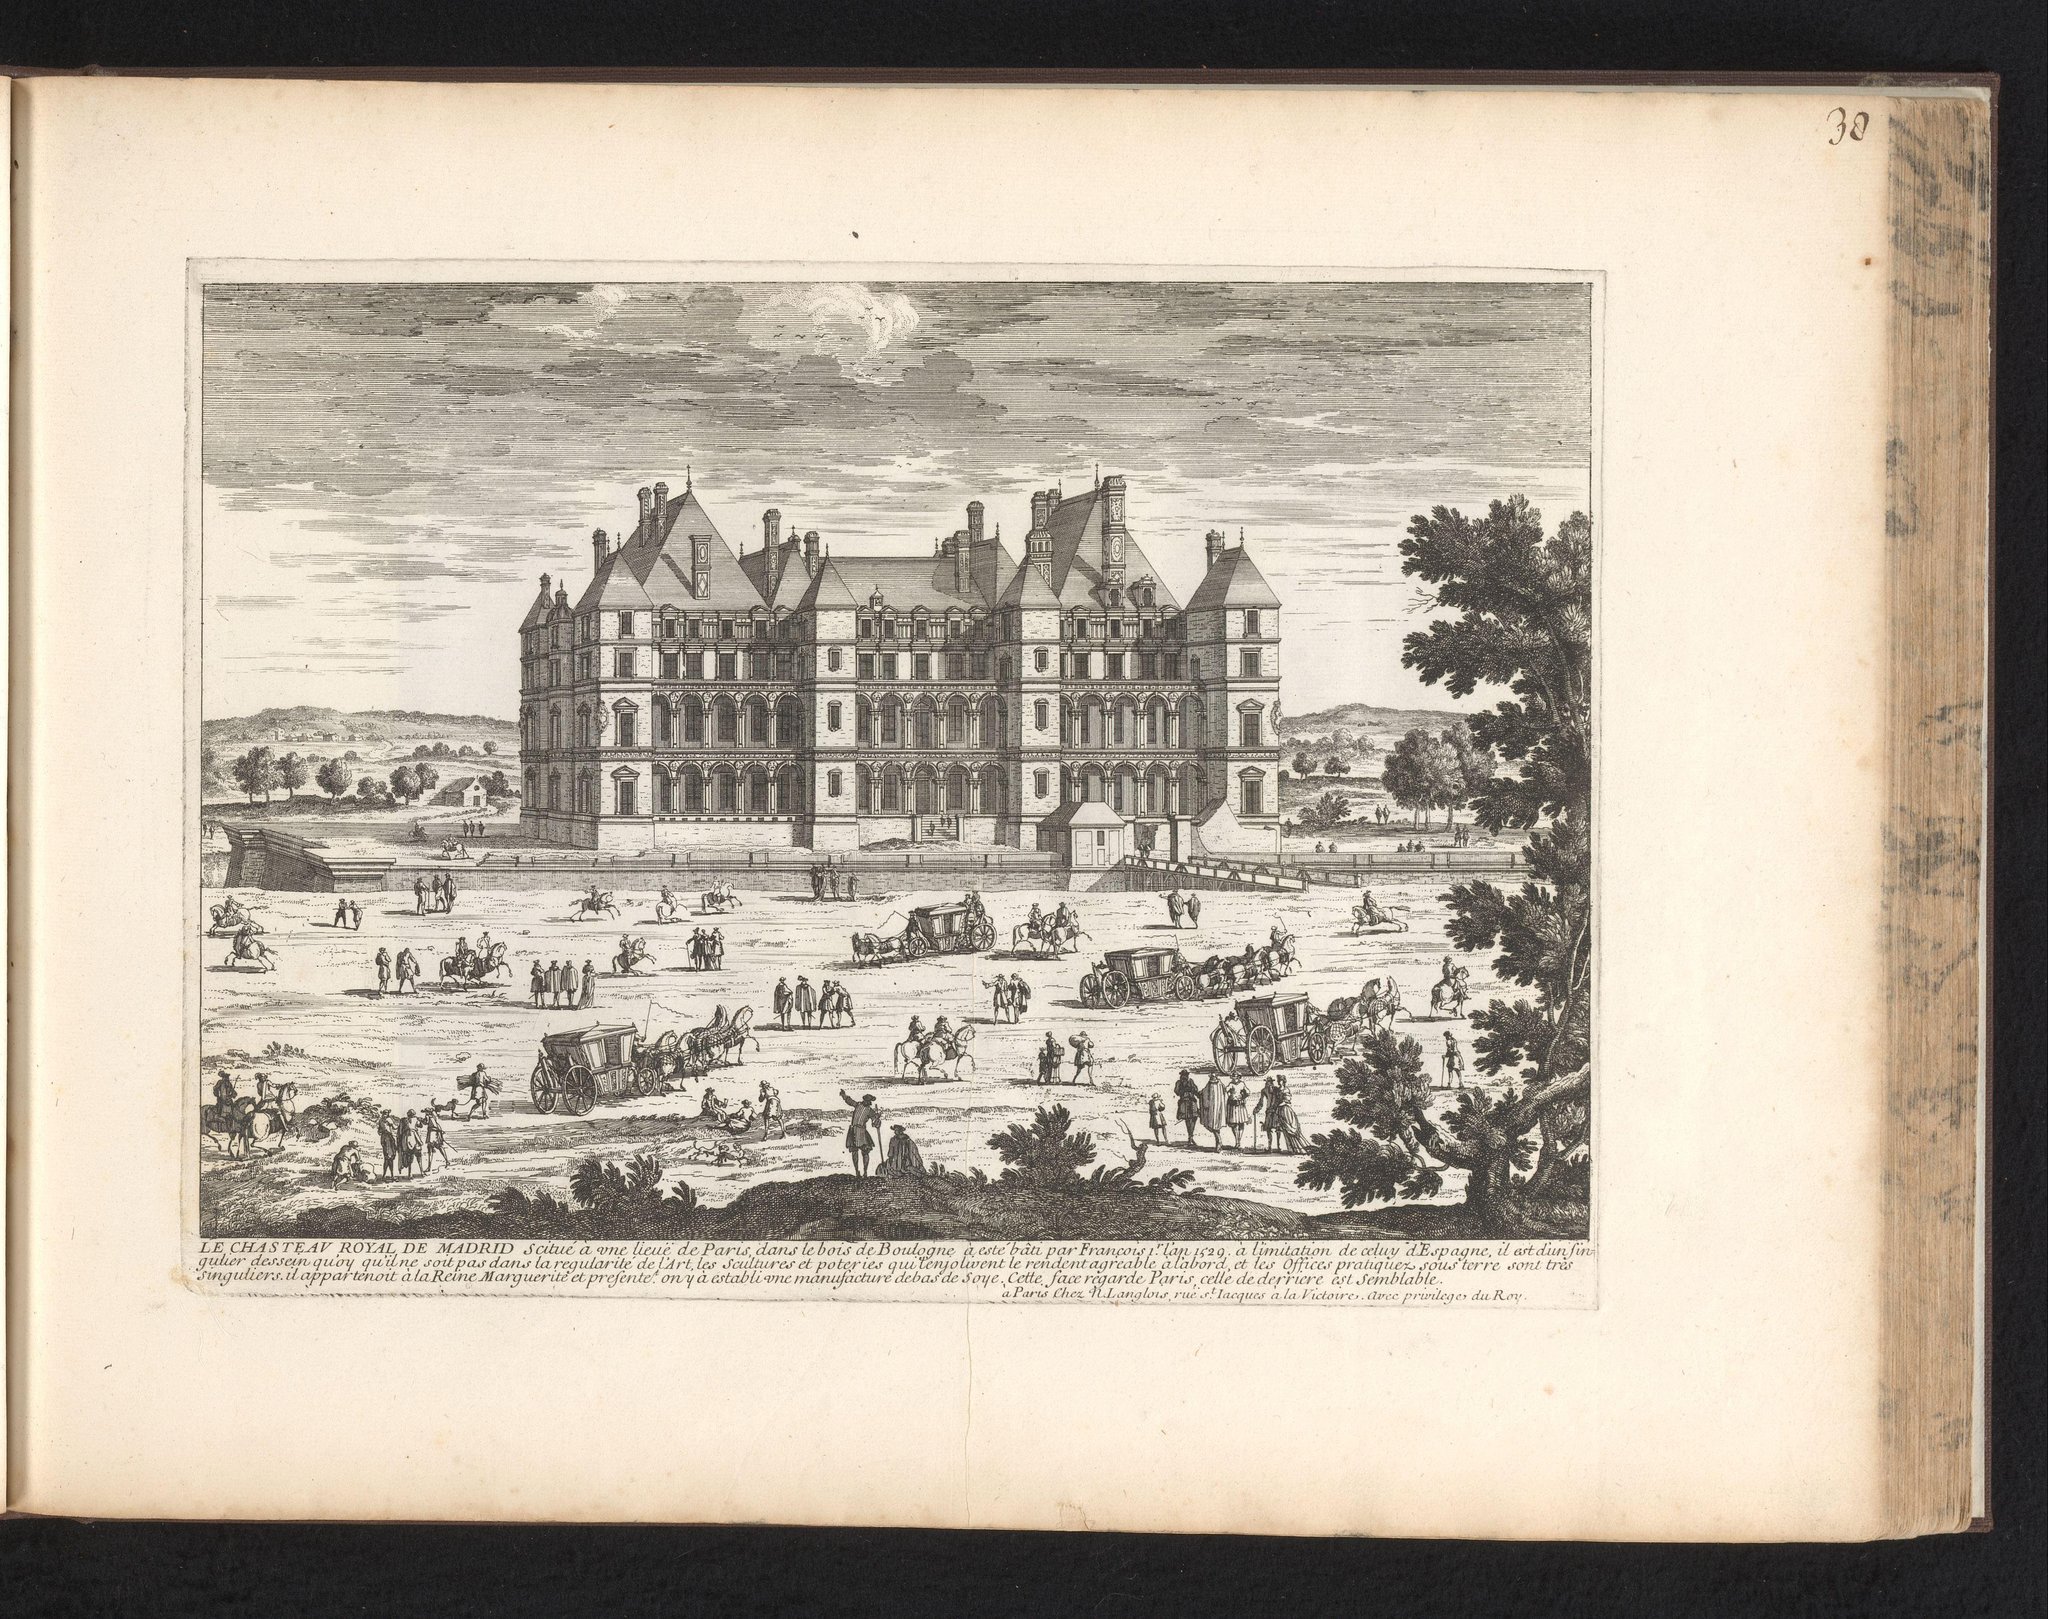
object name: print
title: Le Chasteau Royal de Madrid (...)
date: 1613-1707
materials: paper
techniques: etching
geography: paris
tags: landscape with tower or castle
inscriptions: collector's mark: Lugt 2228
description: Prenten met het signatuur 'Perelle' kunnen zowel door vader Gabriel als door zonen Nicolas en Adam gemaakt zijn. De uitgevers vader en zoon Nicolas Langlois worden allebei vermeld als N. Langlois op hetzelfde adres.